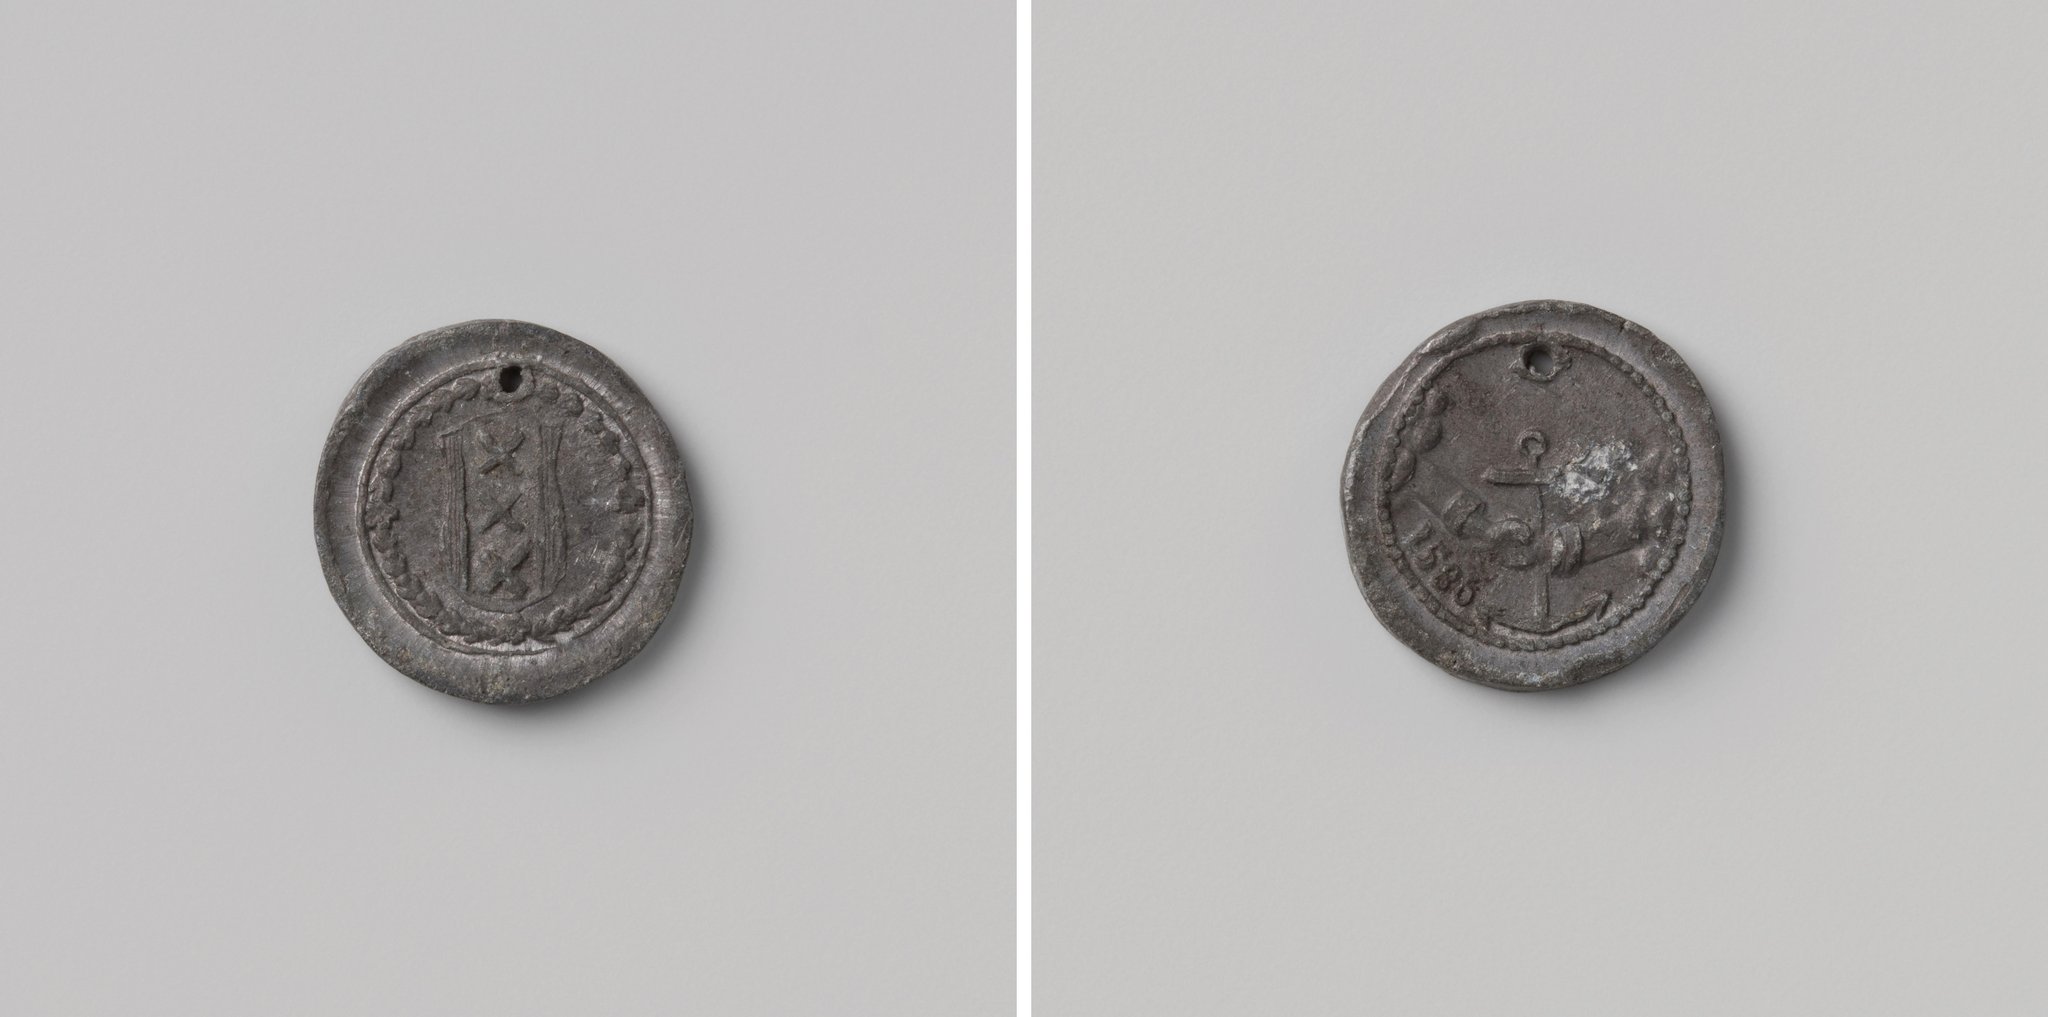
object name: medal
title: Stad Amsterdam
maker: Anonymous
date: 1586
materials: lead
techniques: striking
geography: amsterdam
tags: amsterdam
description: Loden penning. Voorzijde: wapenschild binnen bladerkrans. Keerzijde: twee ineengeslagen handen uit wolken houden gezamelijk anker vast; links onder: jaartal binnen parelrand